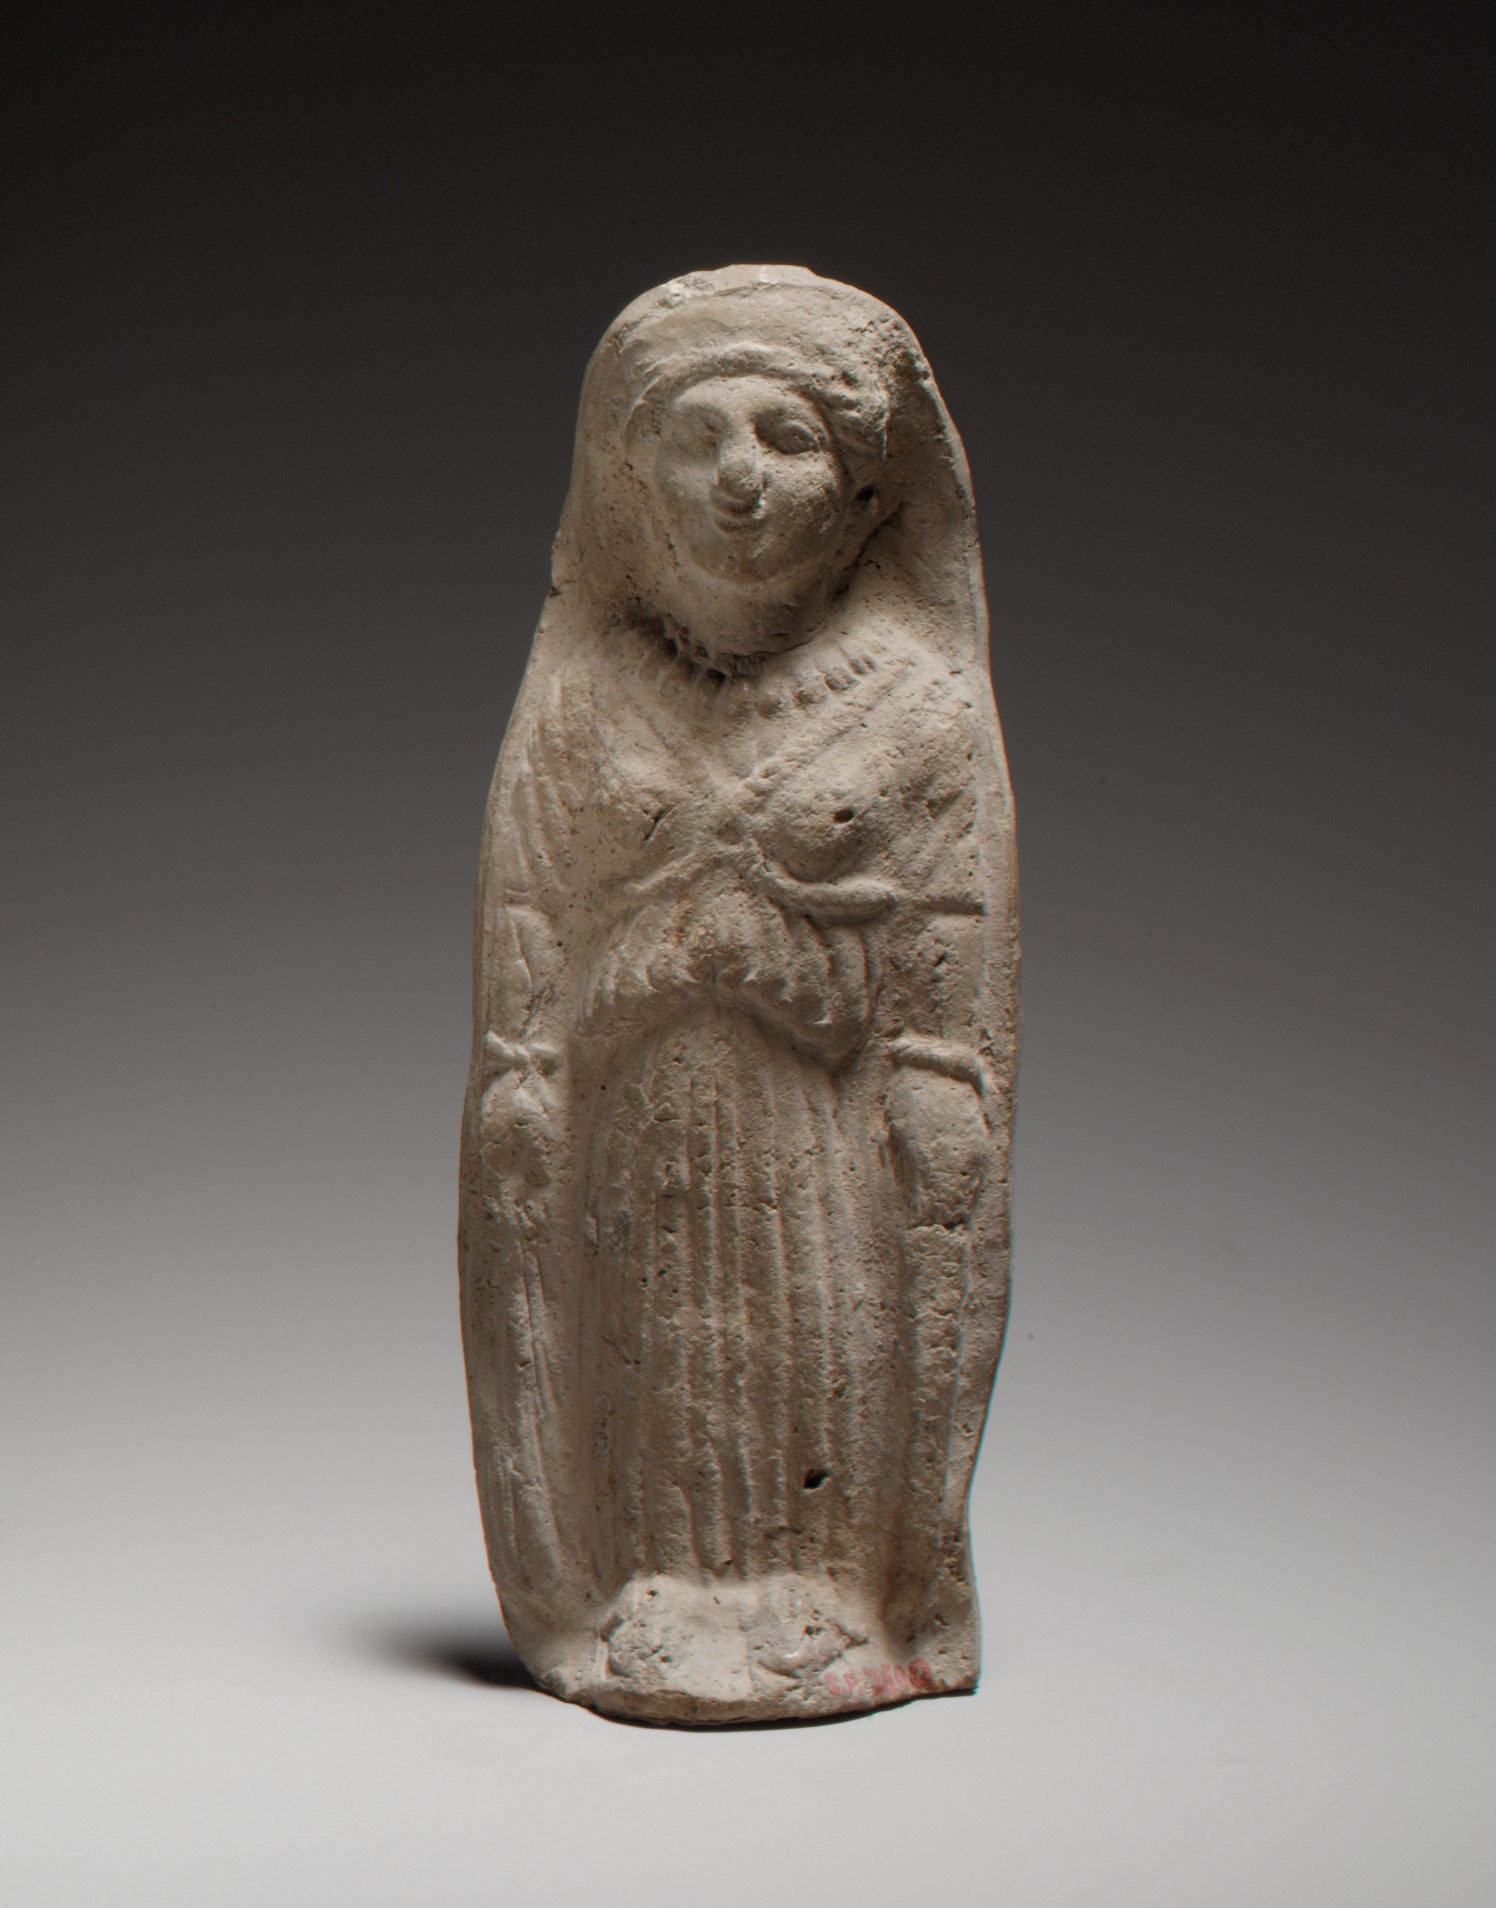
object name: statuette of a female from a ring dance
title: Standing female figurine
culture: cypriot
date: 500-401 BCE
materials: terracotta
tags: women